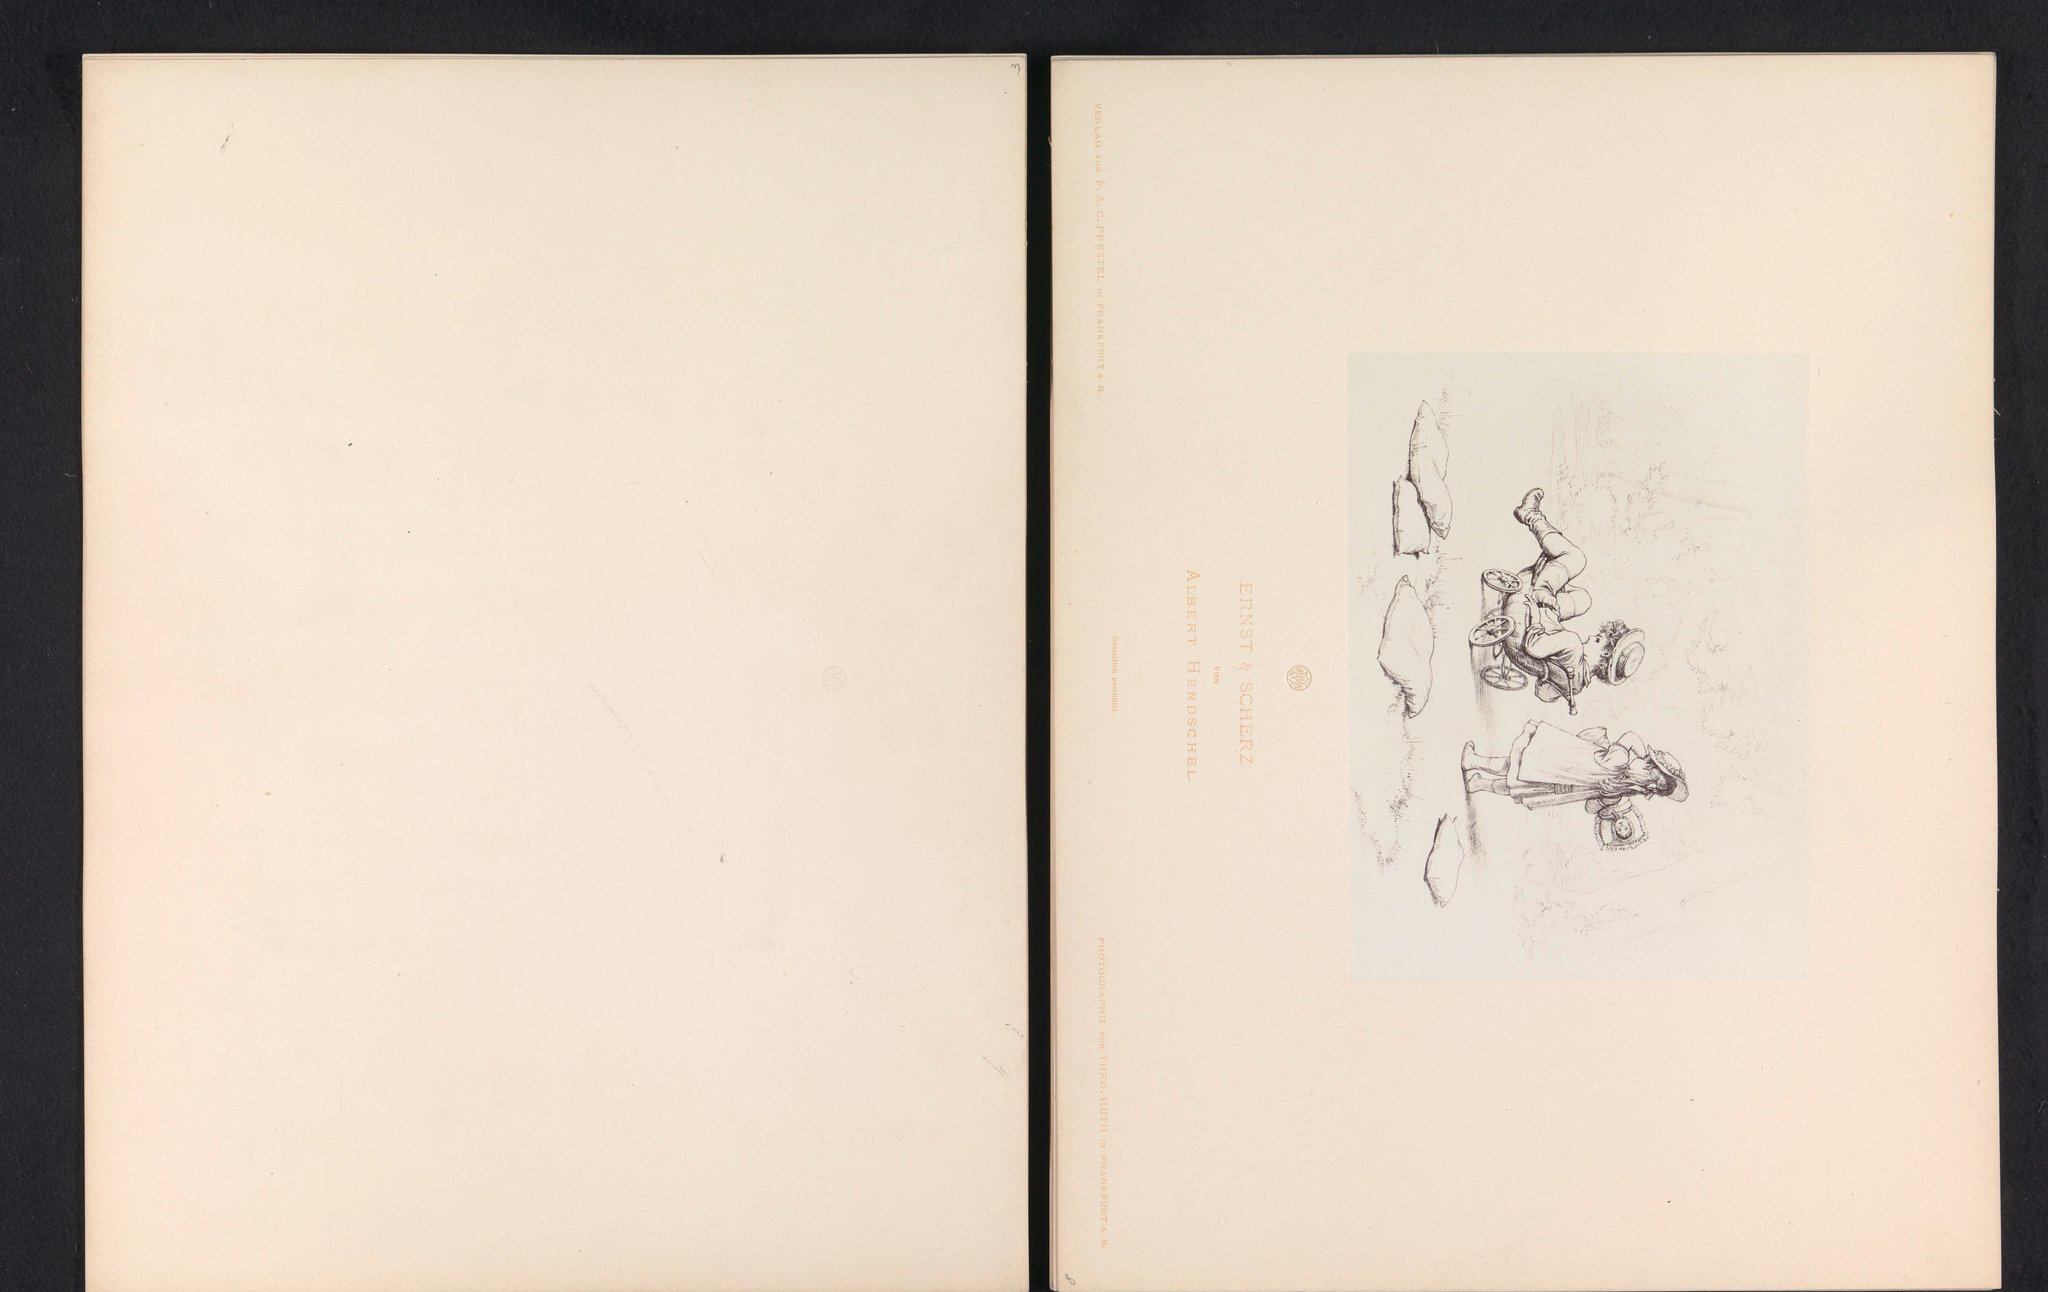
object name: page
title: Fotoreproductie van een tekening van een jongen die in een poppenwagen zit met achter hem een huilend meisje met een pop in haar hand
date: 1869-1879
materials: paper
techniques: woodburytype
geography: frankfurt am main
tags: child, (playing with) dolls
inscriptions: initials: ‘[...]’